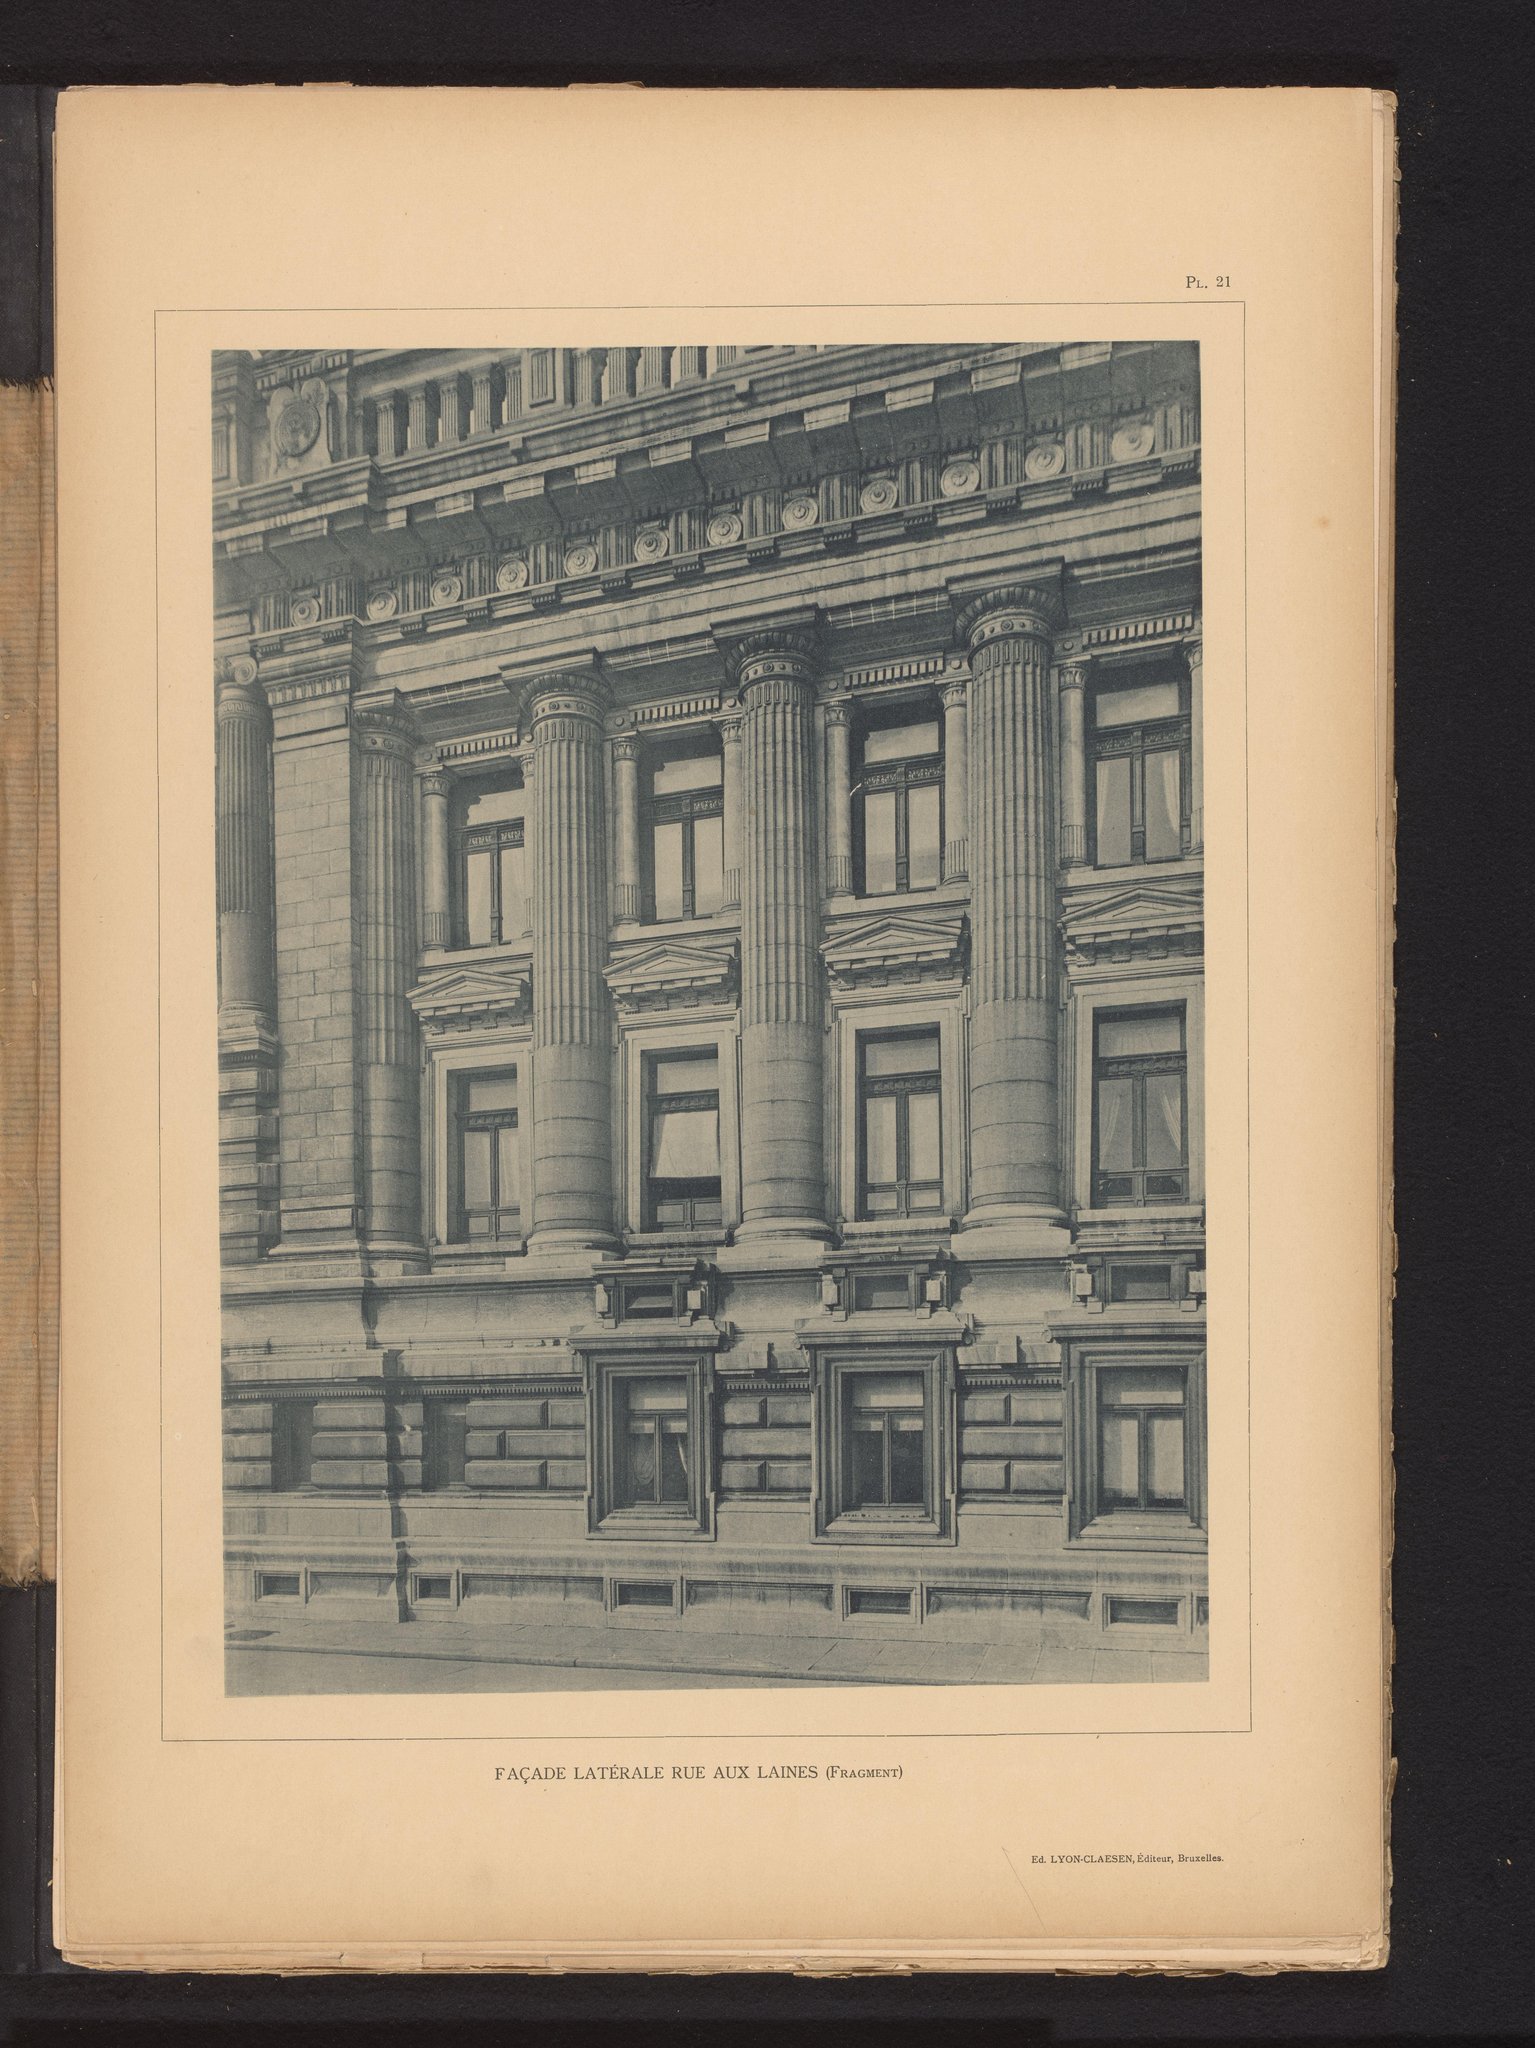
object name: photomechanical print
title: Façade Latérale Rue aux Laines (Fragment)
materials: paper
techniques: photograph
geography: brussels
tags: court building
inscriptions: number: ‘PL. 21’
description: Deze prent maakt deel uit van een omslag met 30 prenten op 28 bladen en een titelblad.